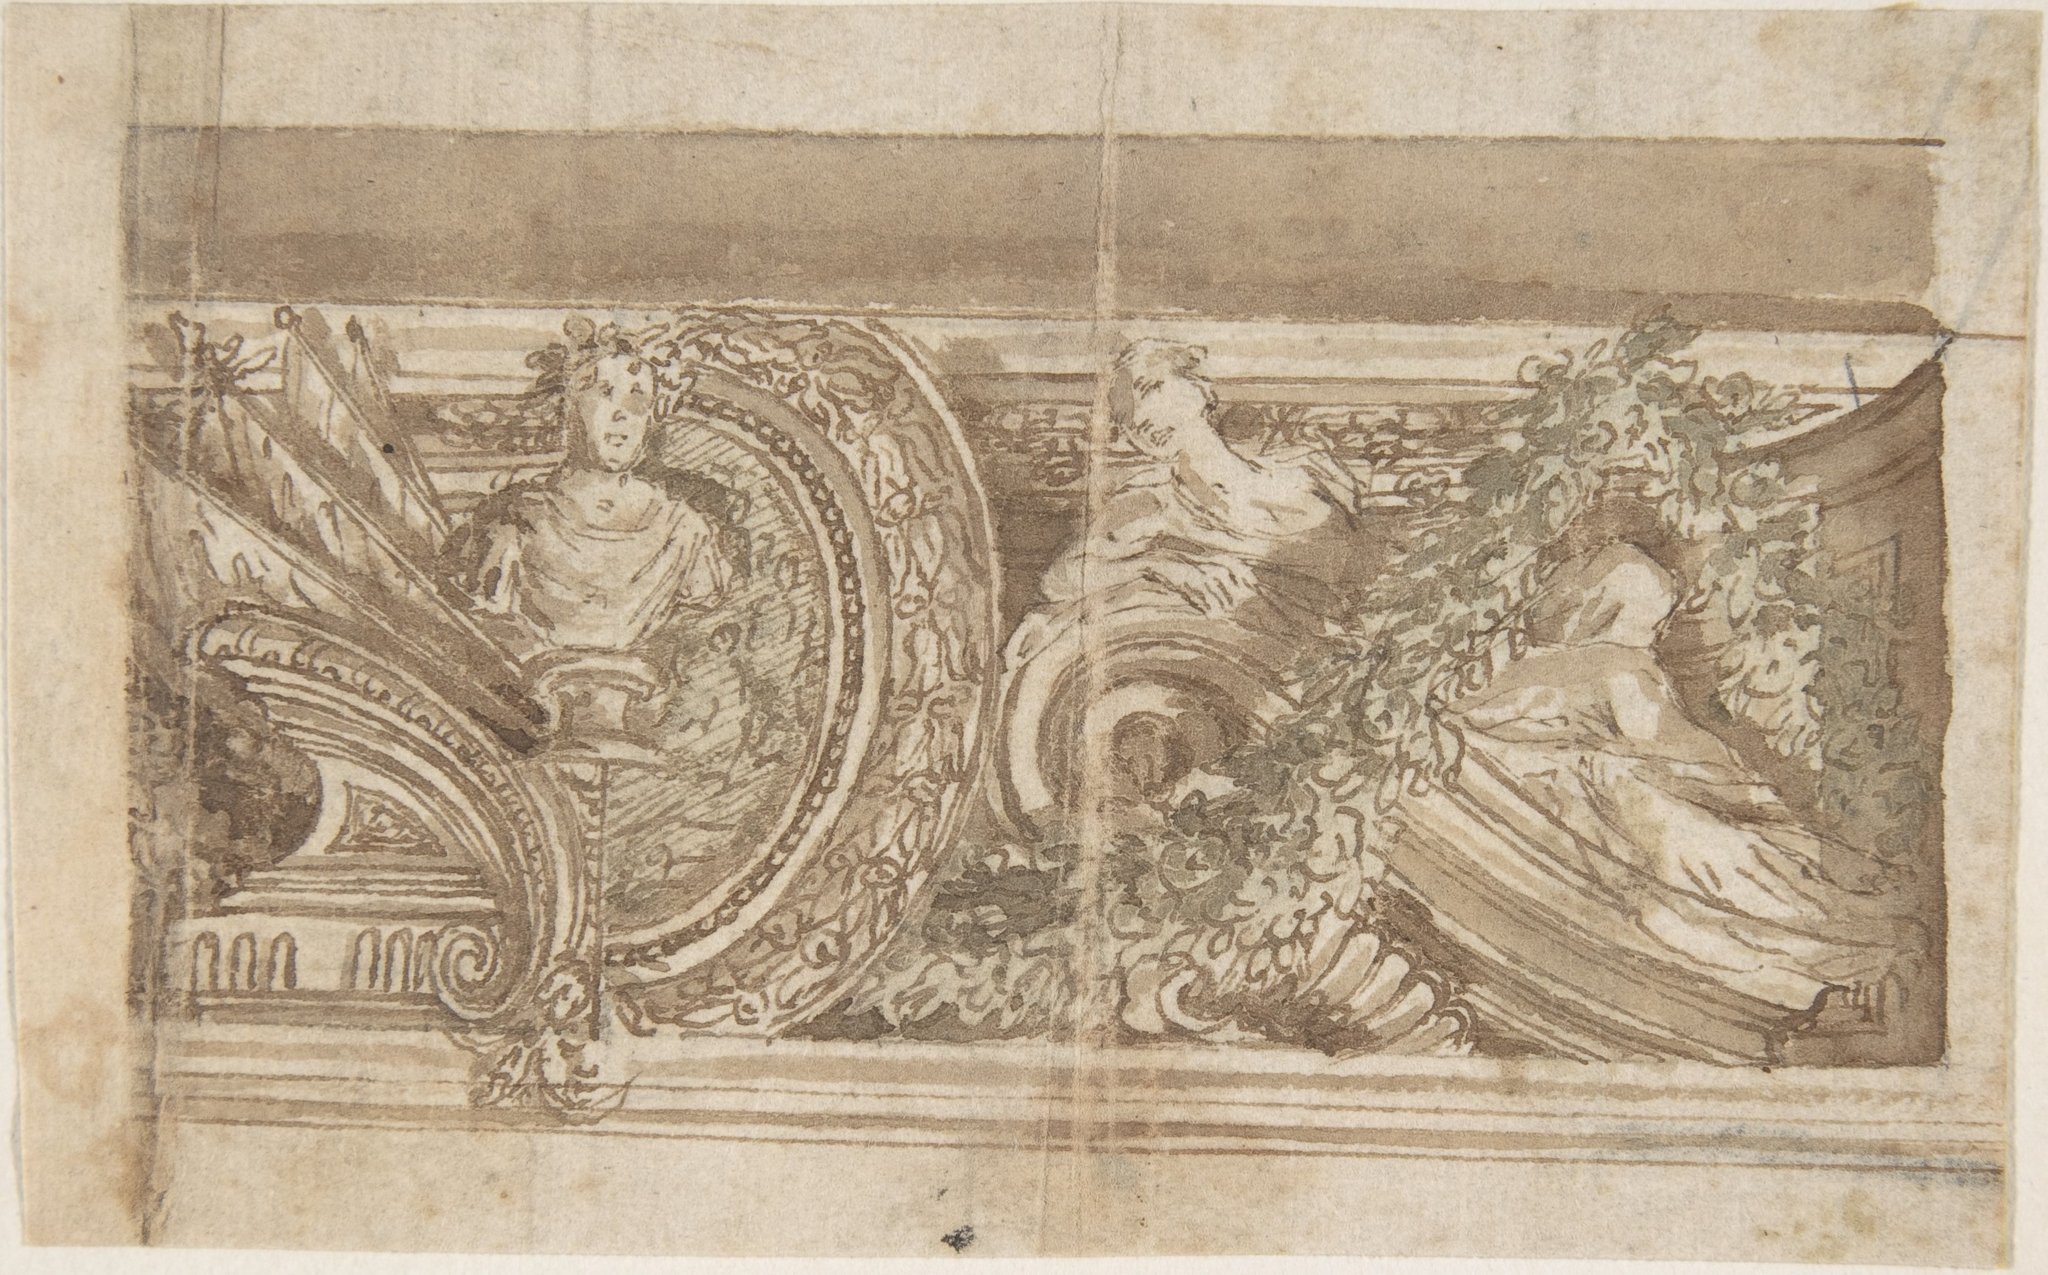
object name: drawing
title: Design for Part of a Decorated Cornice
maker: anonymous, french, 17th century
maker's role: artist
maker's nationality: french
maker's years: 1600-1700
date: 1601-1700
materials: ink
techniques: brush, pen, wash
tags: ornament